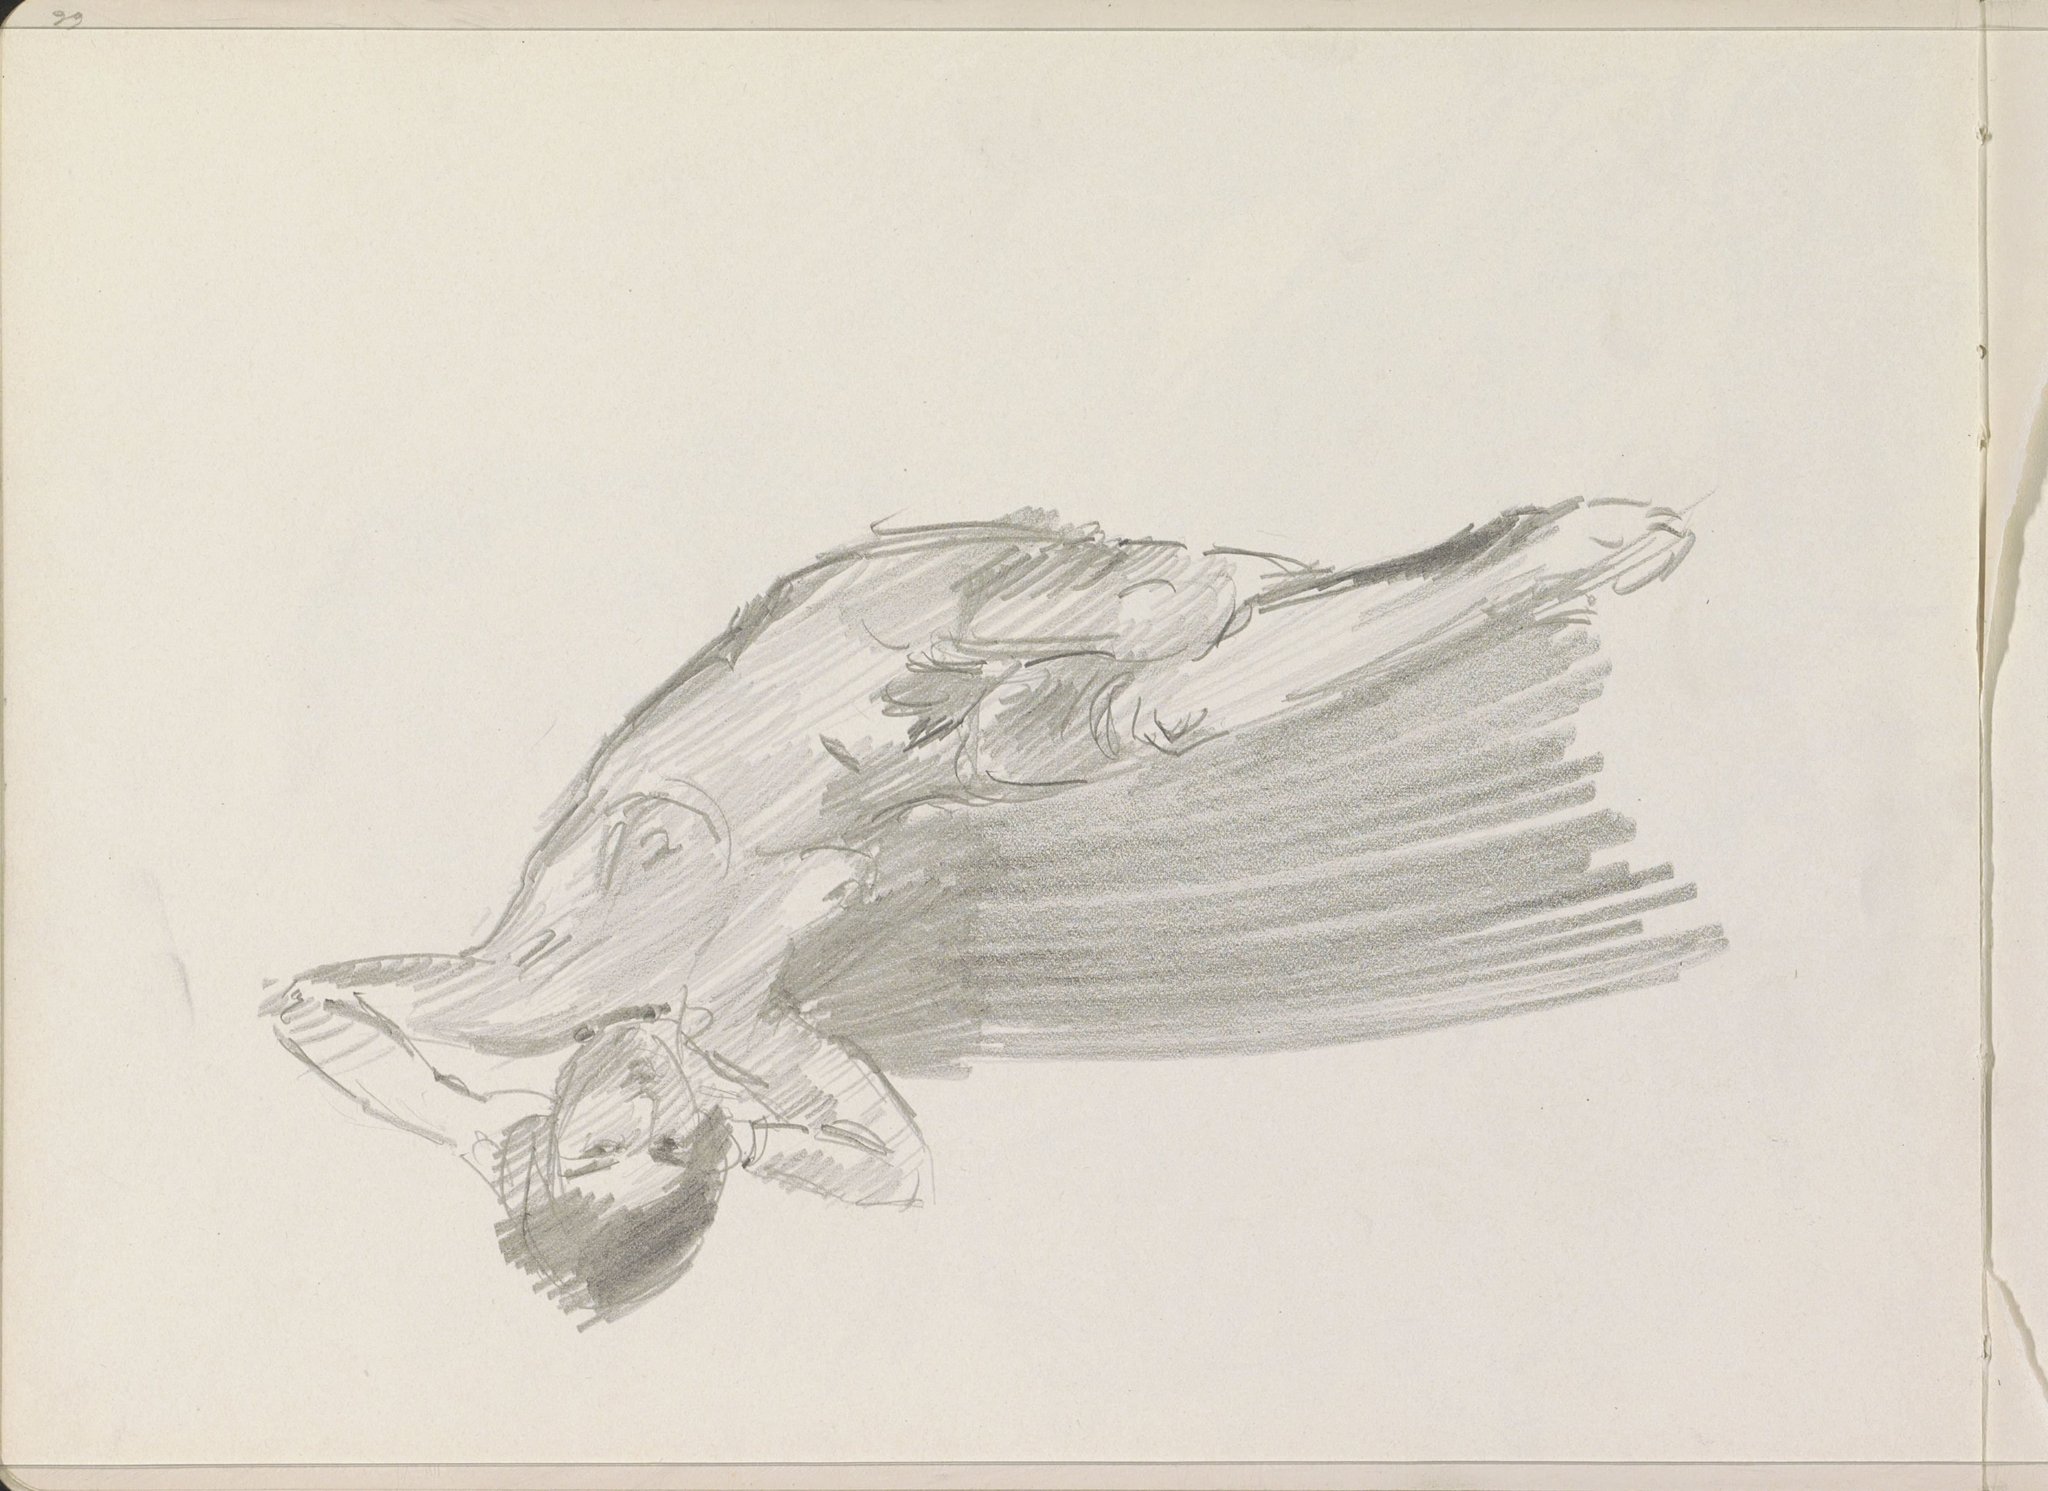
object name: sketchbook leaf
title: Reclining Female Nude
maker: isaac israels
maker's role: draughtsman, painter, print maker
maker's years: 1865-1934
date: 1915-1934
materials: paper, pencil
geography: the hague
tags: the (nude) human figure; 'corpo humano' (ripa) - aa - female human figure (+ lying)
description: Met haar handen achter haar hoofd. Blad 7 verso uit schetsboek III met 36 bladen.